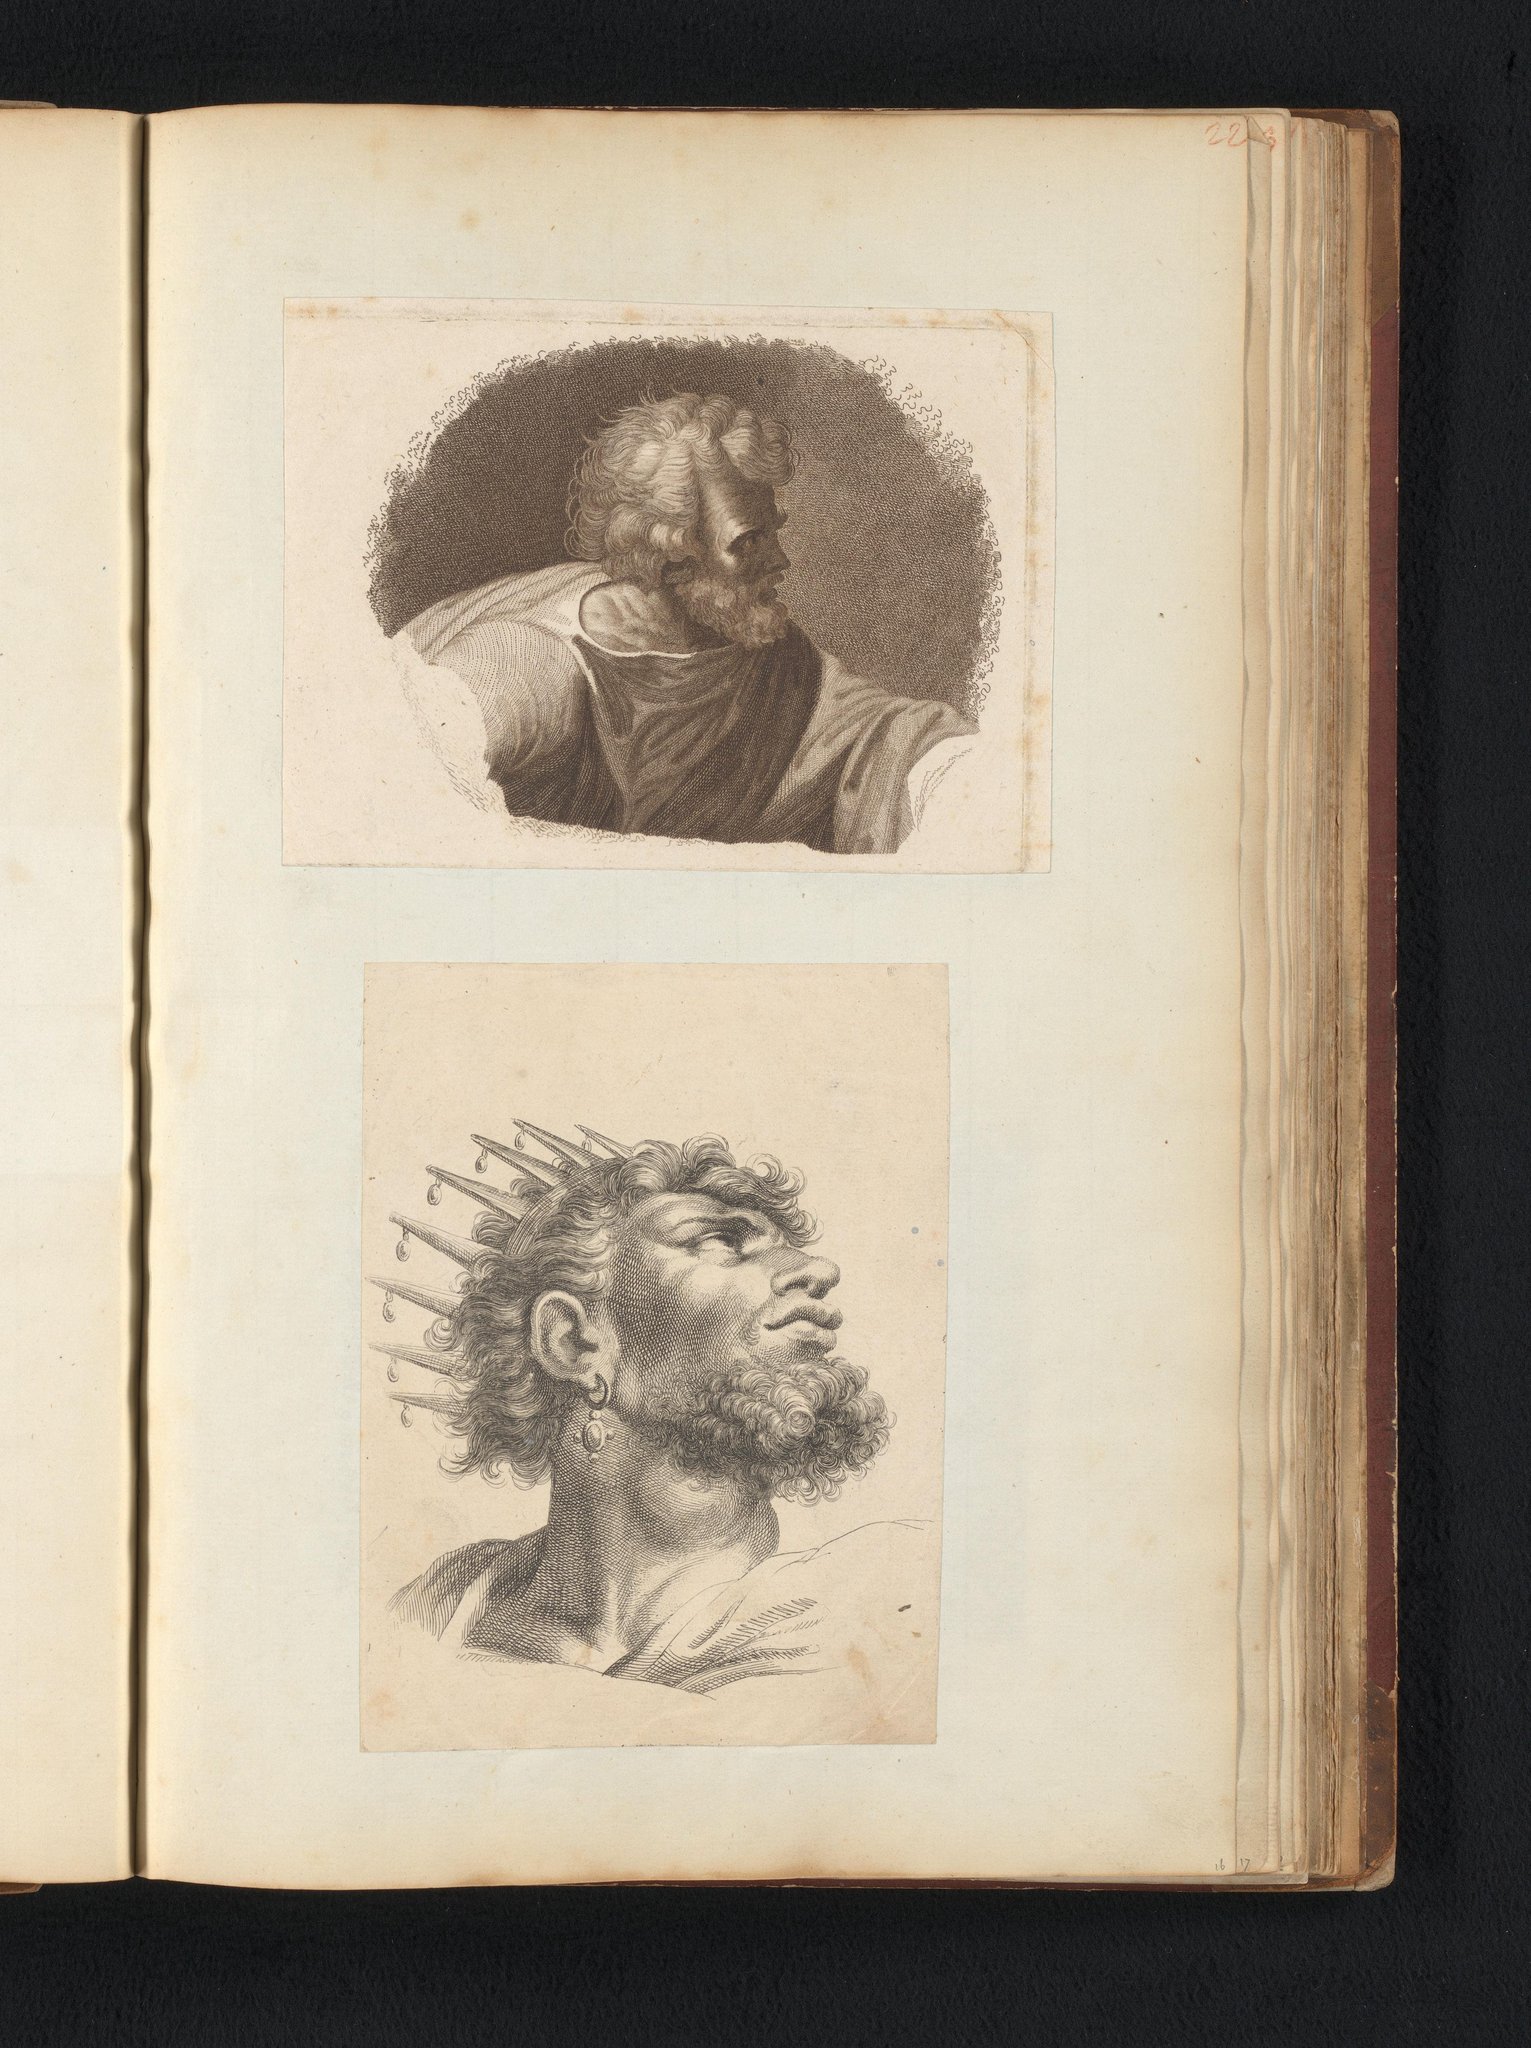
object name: album leaf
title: Historische koppen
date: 1750-1816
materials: paper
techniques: engraving, etching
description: Twee historische mannenkoppen. Onderdeel van het tweede van twee albums met ingeplakte prenten en tekeningen te dienen als tekenvoorbeelden.